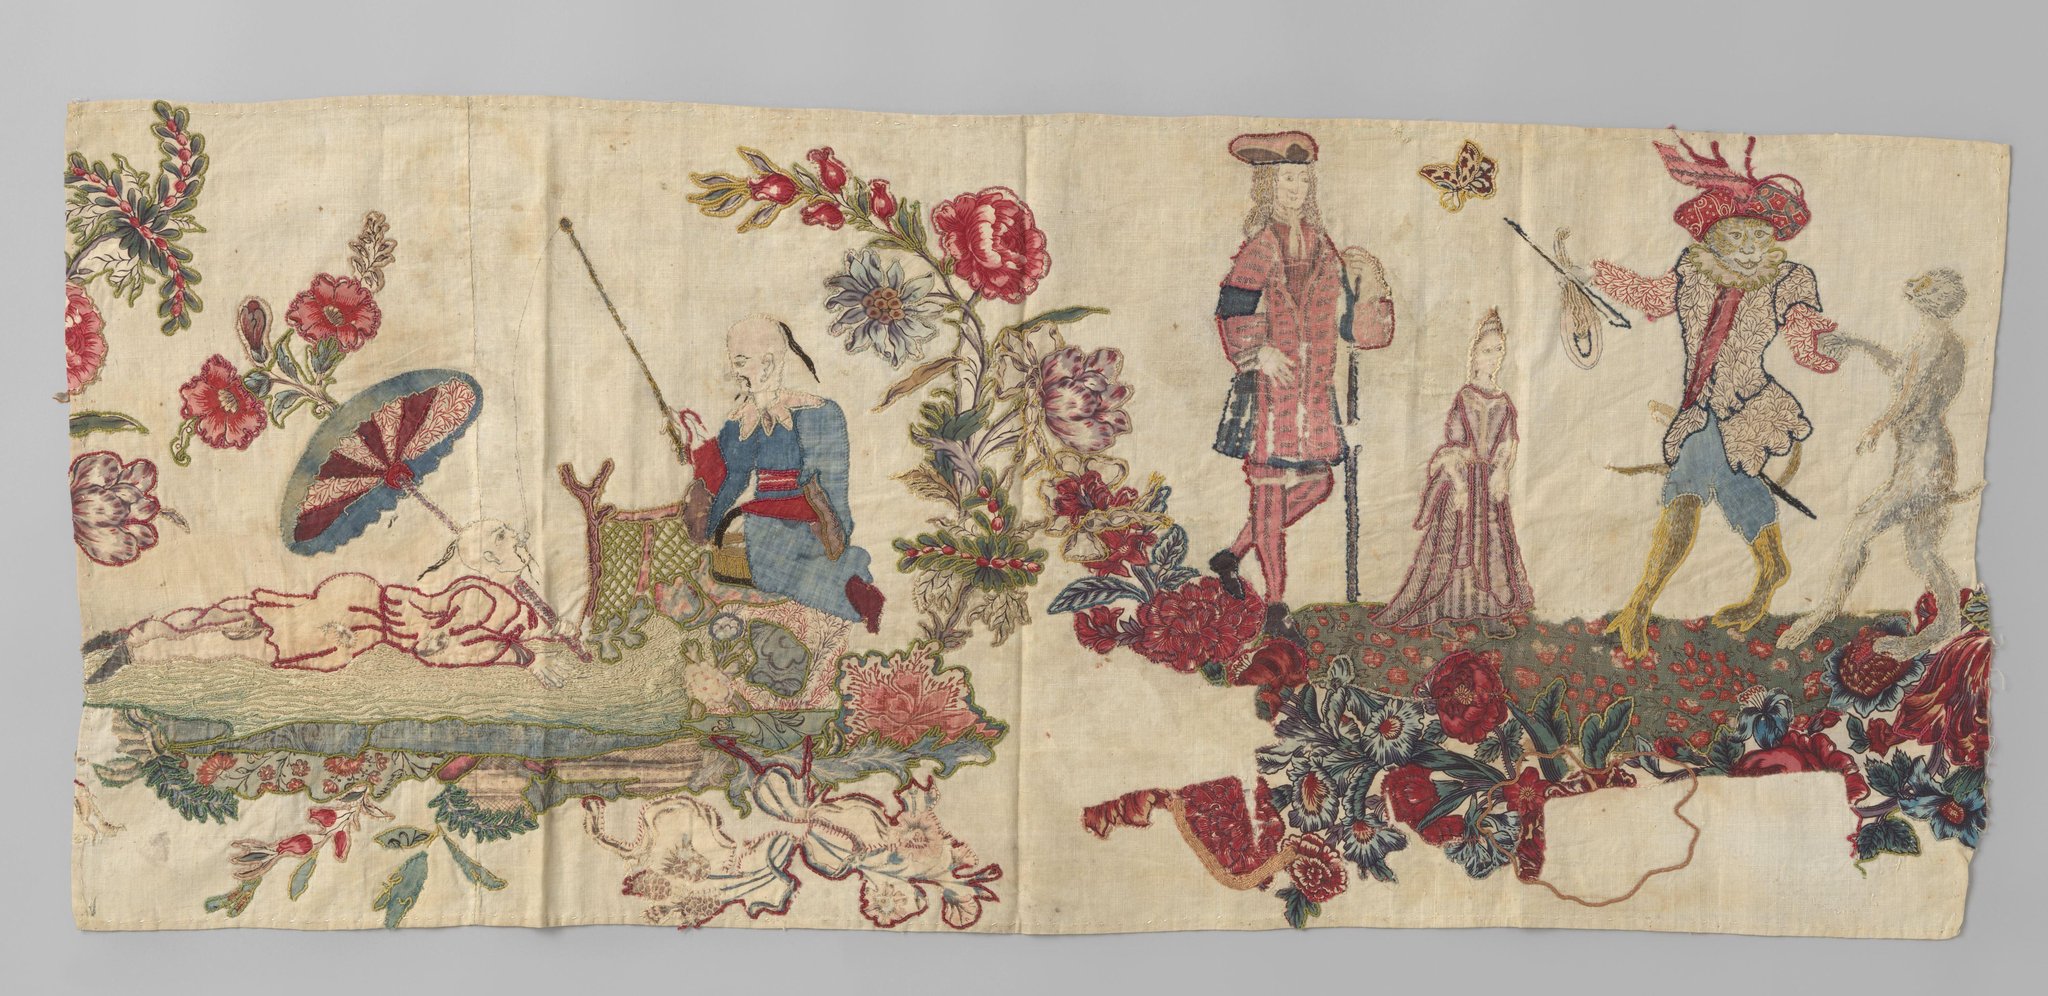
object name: bed covering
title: Lambrekijn of fragment met chinoiserieën in sitsen applicatie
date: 1700-1750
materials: linen, textile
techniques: printing, weave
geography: india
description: Lambrekijn of fragment met een afbeelding van een Chinese hengelaar. In een door bloemtakken omgeven middentafereel zit een Chinese man te hengelen naar een in een vijver zwemmende Chinees met parasol. Rechts staan een europese een man en een vrouw die kijken naar twee dansende apen. De lambrekijn hoort bij drie lambrekijns (of fragmenten) met invnr. BK-16441-B t/m BK-16441-E en een sprei met invnr. BK-16441-A. Oosterse textiel.